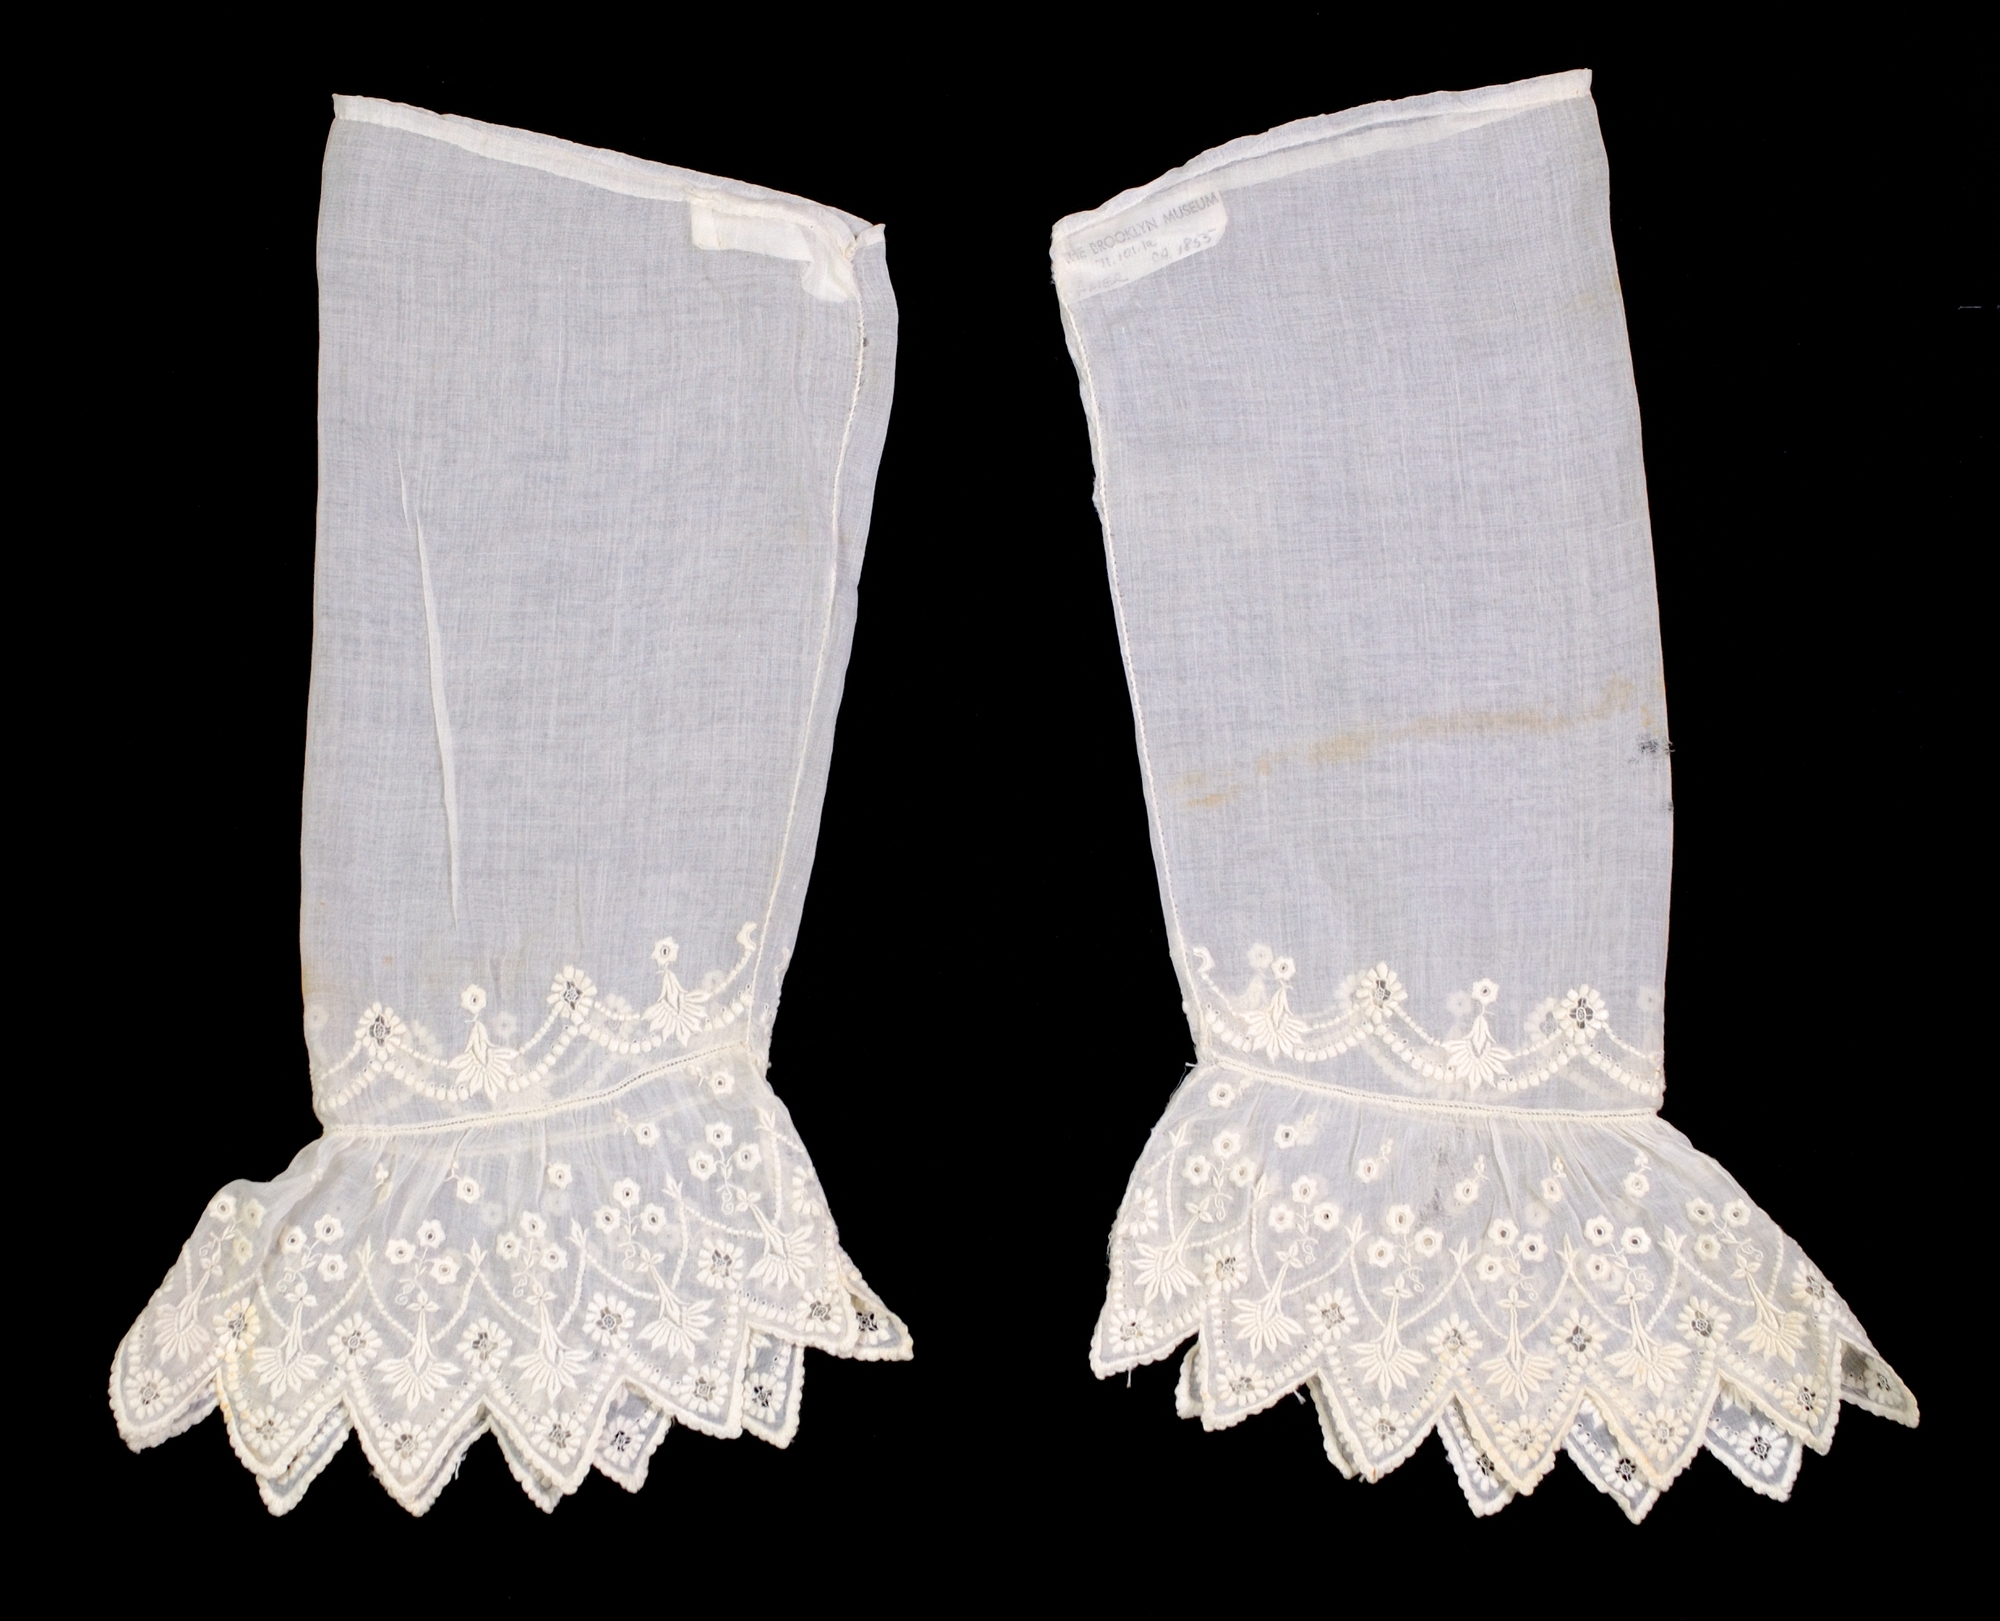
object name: undersleeves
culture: american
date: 1855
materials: cotton